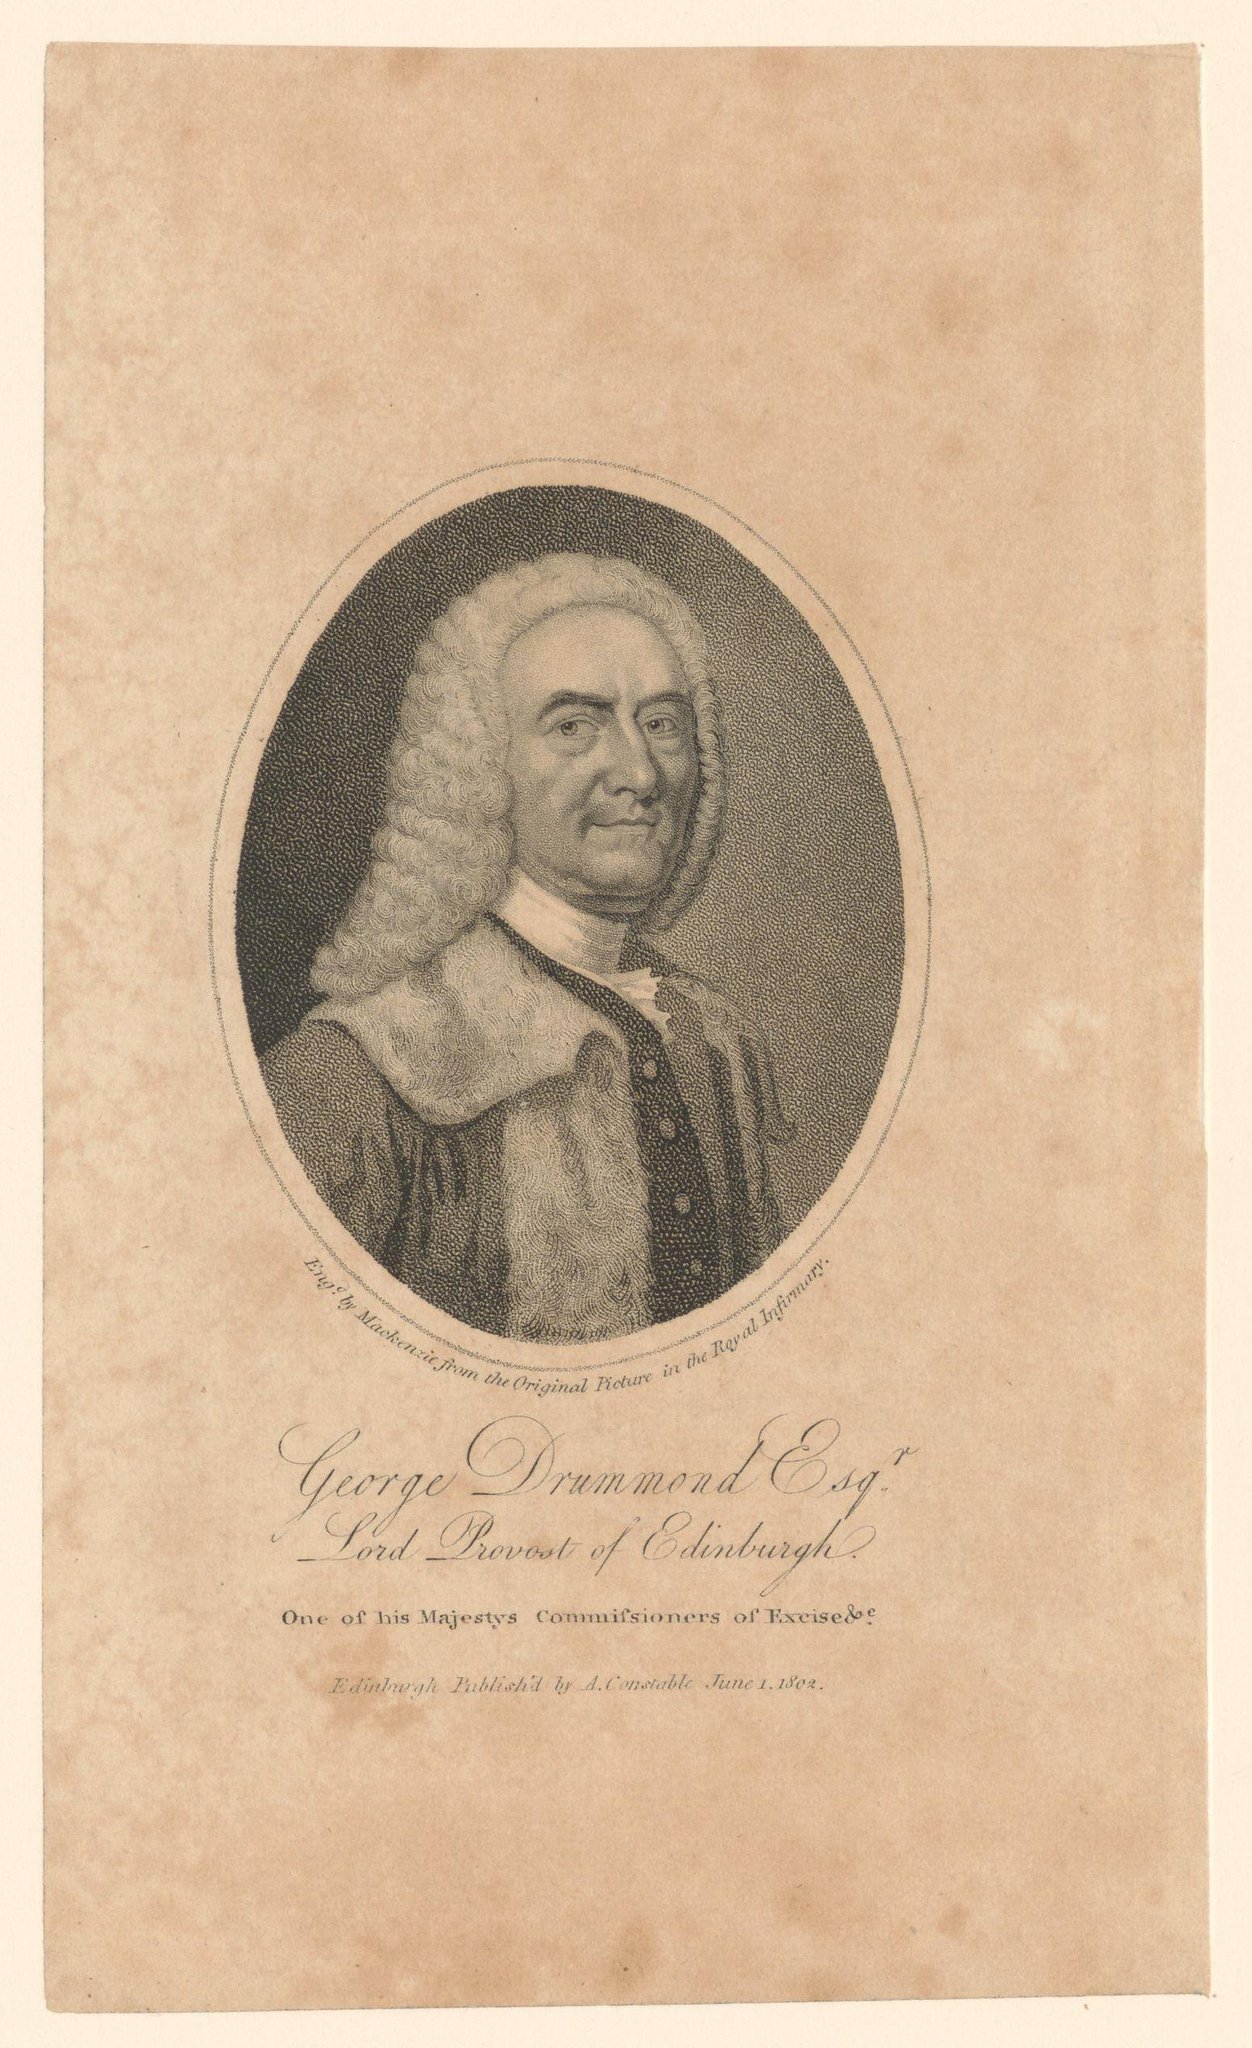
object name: print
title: Portret van George Drummond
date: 1802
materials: paper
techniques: stippling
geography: edinburgh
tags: politician, historical persons, politician, e.g. party leader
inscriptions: collector's mark: Lugt 2228